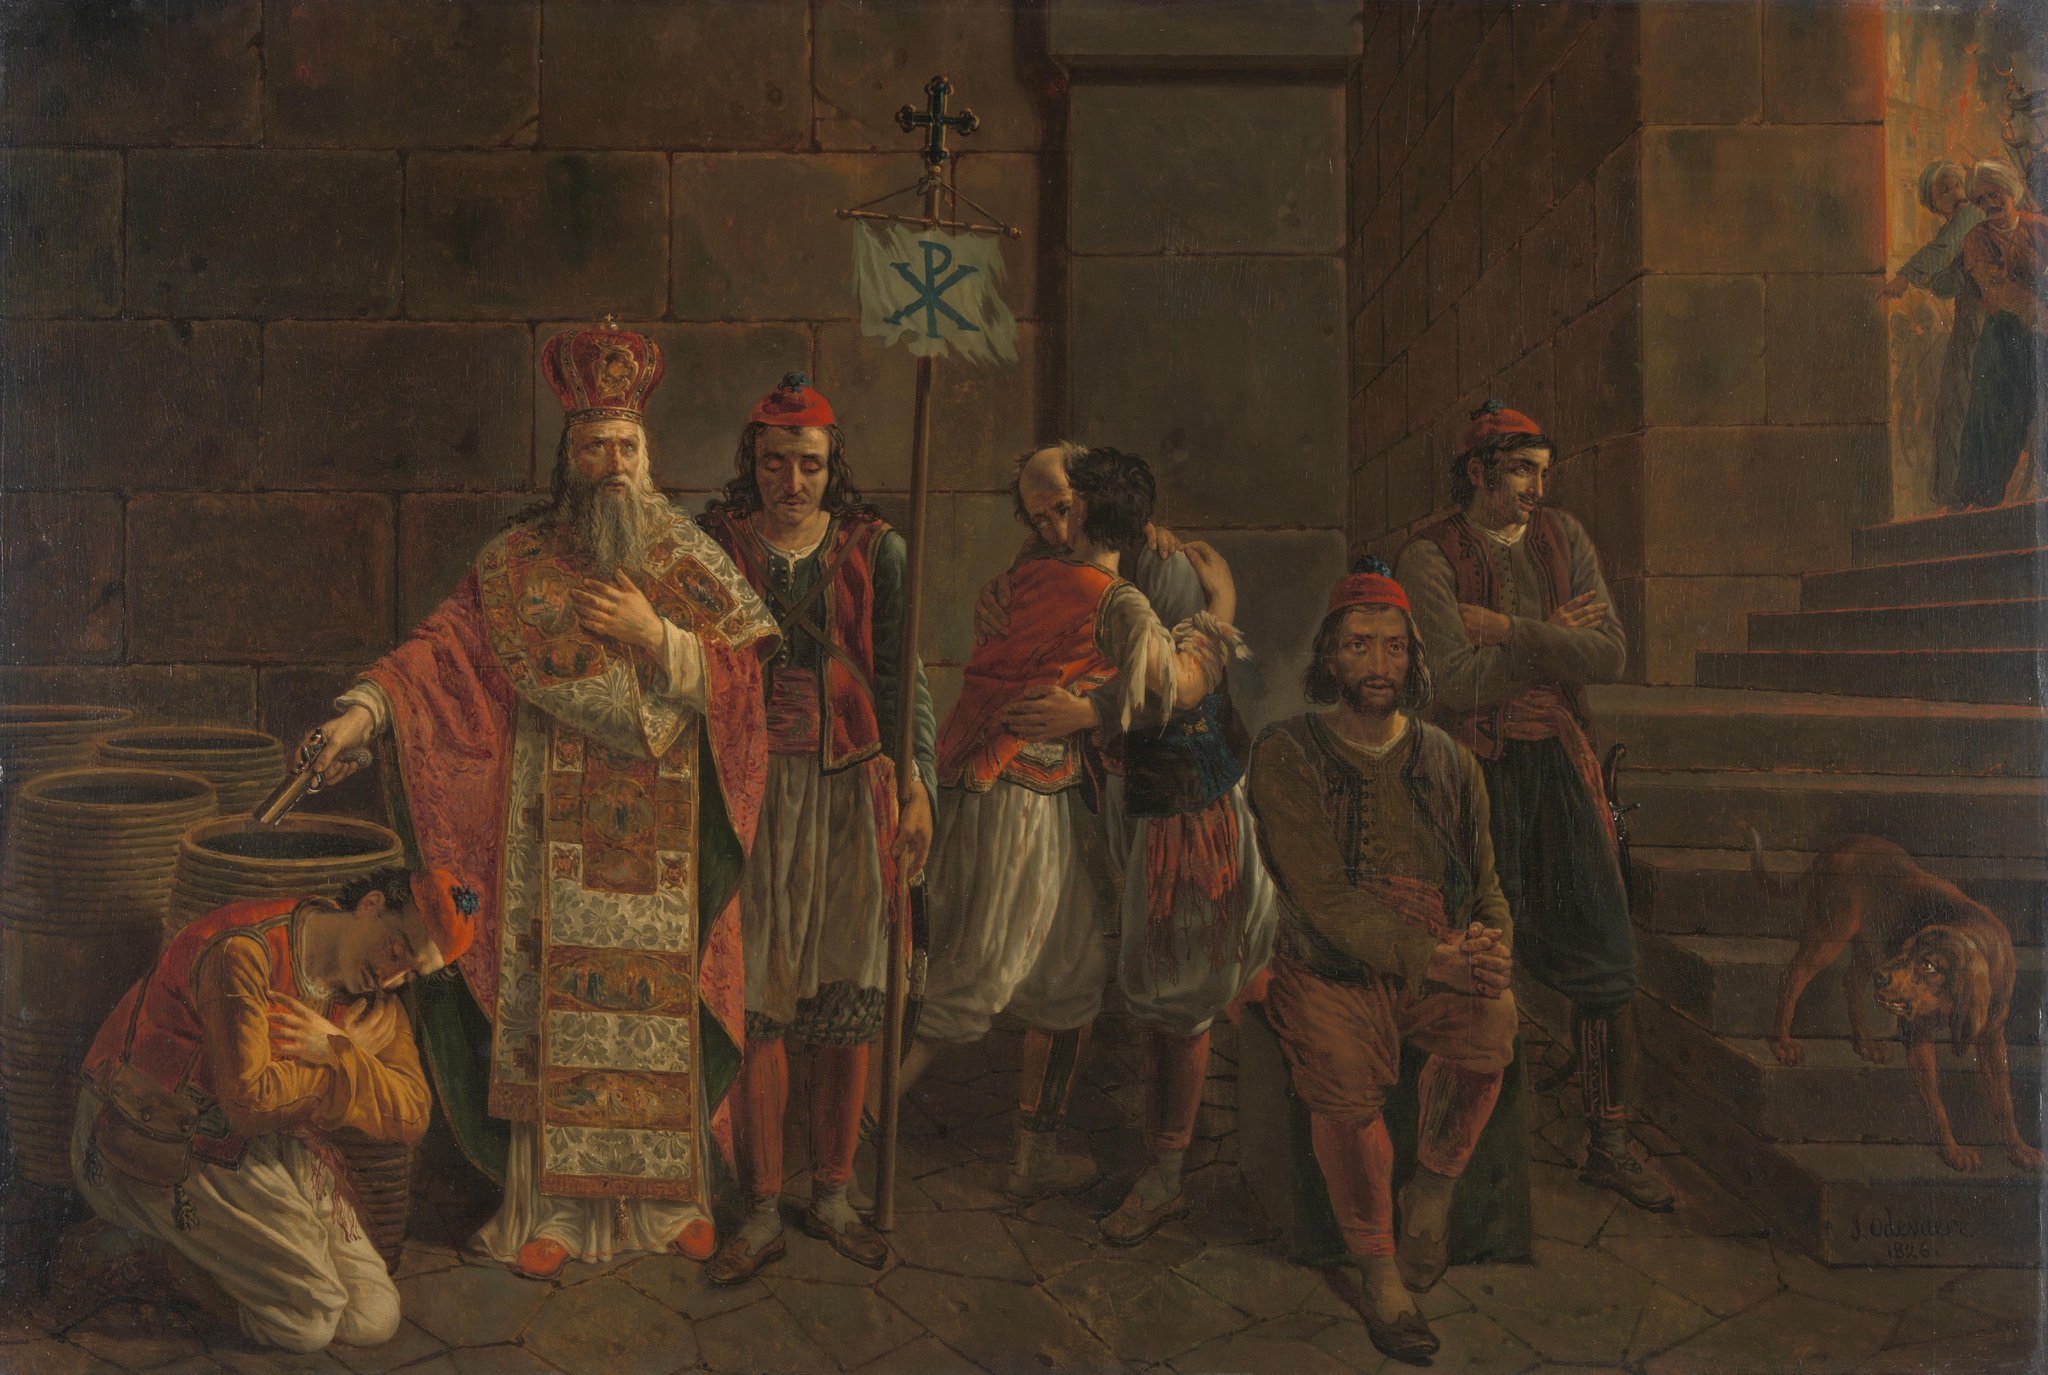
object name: painting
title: The Last Defenders of Missolonghi, 22 April 1826: an episode from the Greek War of Independence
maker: joseph-denis odevaere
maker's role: painter, print maker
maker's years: 1778-1830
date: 1826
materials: oil, paint, panel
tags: seeking death, suicide, the defeated (after the battle)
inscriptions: signature and date: ‘J. Odevaere 1826’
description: De laatste verdedigers van Missolonghi (Mesolongi), 22 april 1826: episode uit de Griekse vrijheidsoorlog. De overgebleven inwoners van de stad staan op het punt zichzelf met vaten buskruit op te blazen. Enkele mannen omhelzen elkaar, een hogepriester richt een pistool op een vat met buskruit, rechts een hond. Rechts bovenaan de trap de naderende Turkse soldaten.